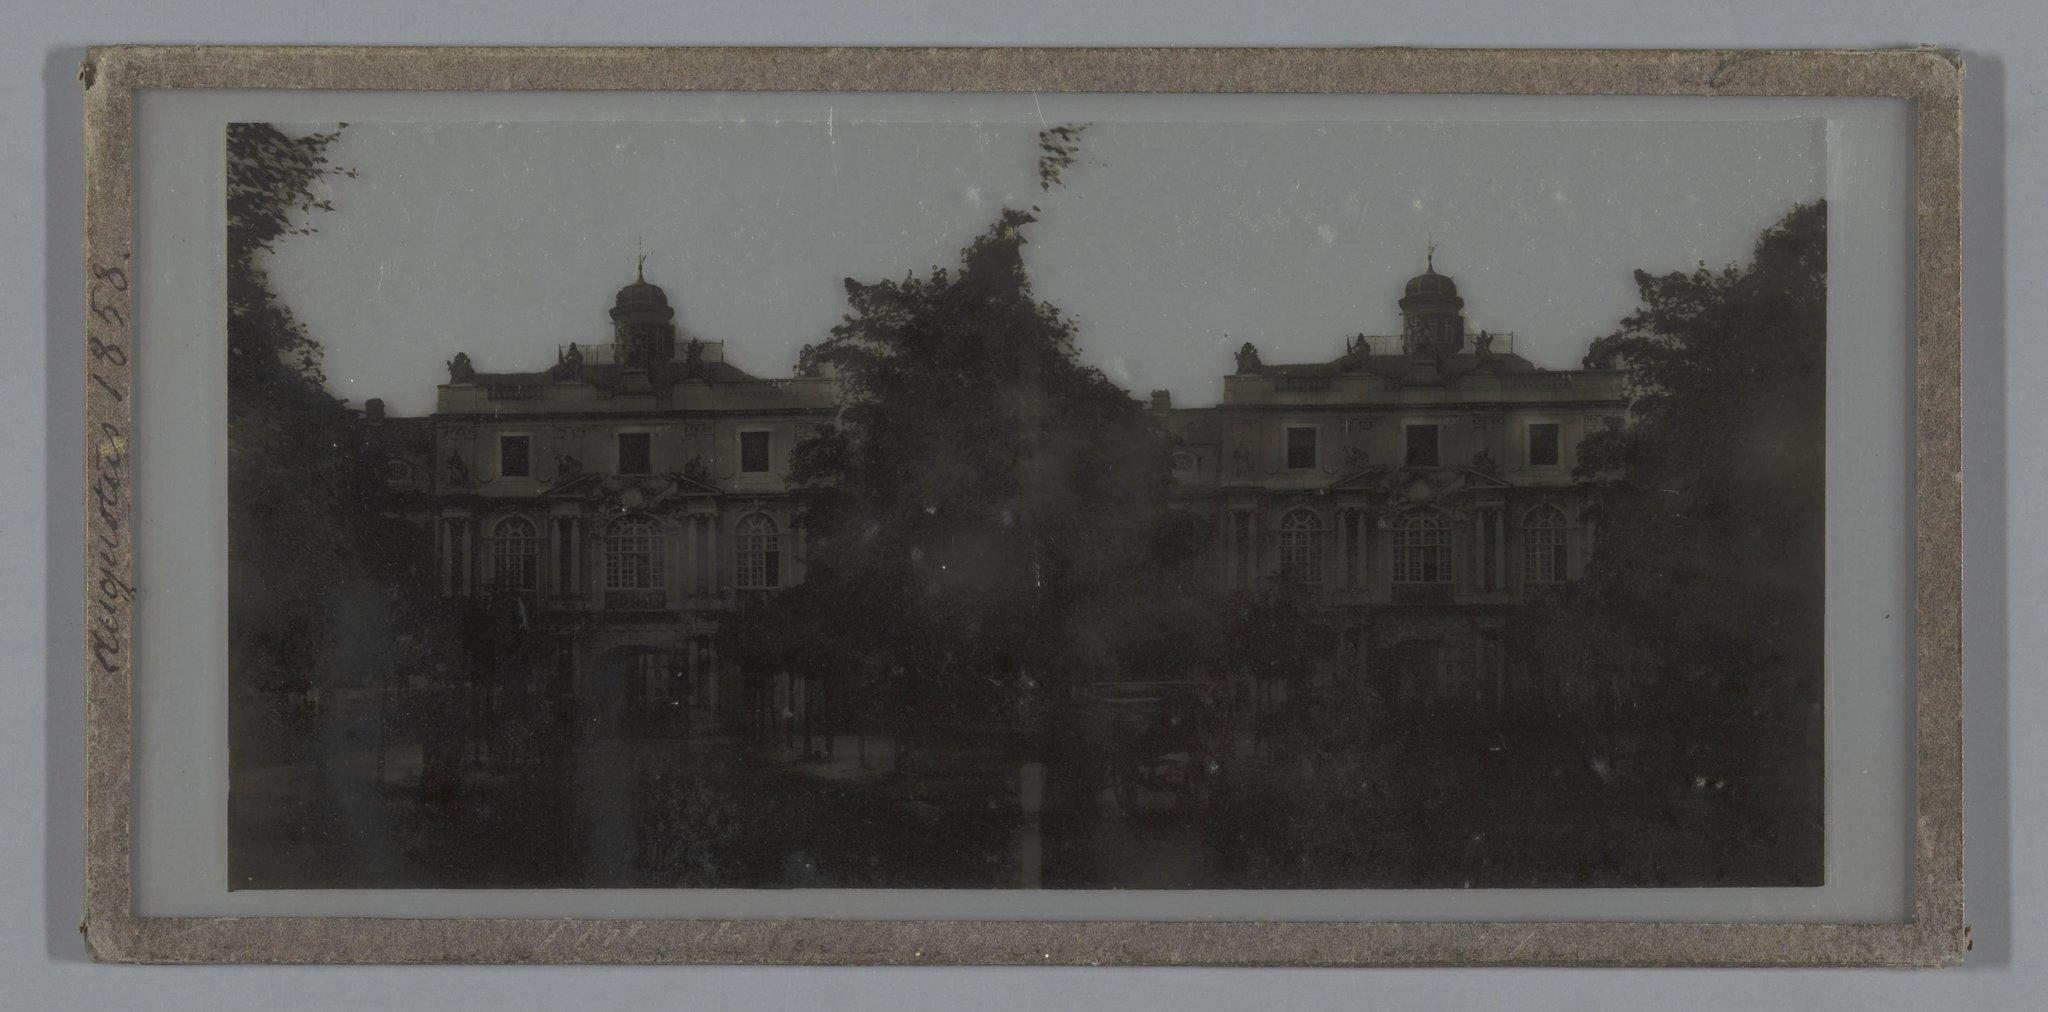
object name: stereoscopic photograph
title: Gezicht op de de Rheinischen Friedrich-Wilhelms-Universität in het Kurfürstliches Schloss in Bonn, Duitsland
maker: Anonymous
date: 1808-1858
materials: glass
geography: bonn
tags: electoral palace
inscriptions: inscription: ‘aug s 1858’, inscription: ‘l' art de [...] a Bonn’